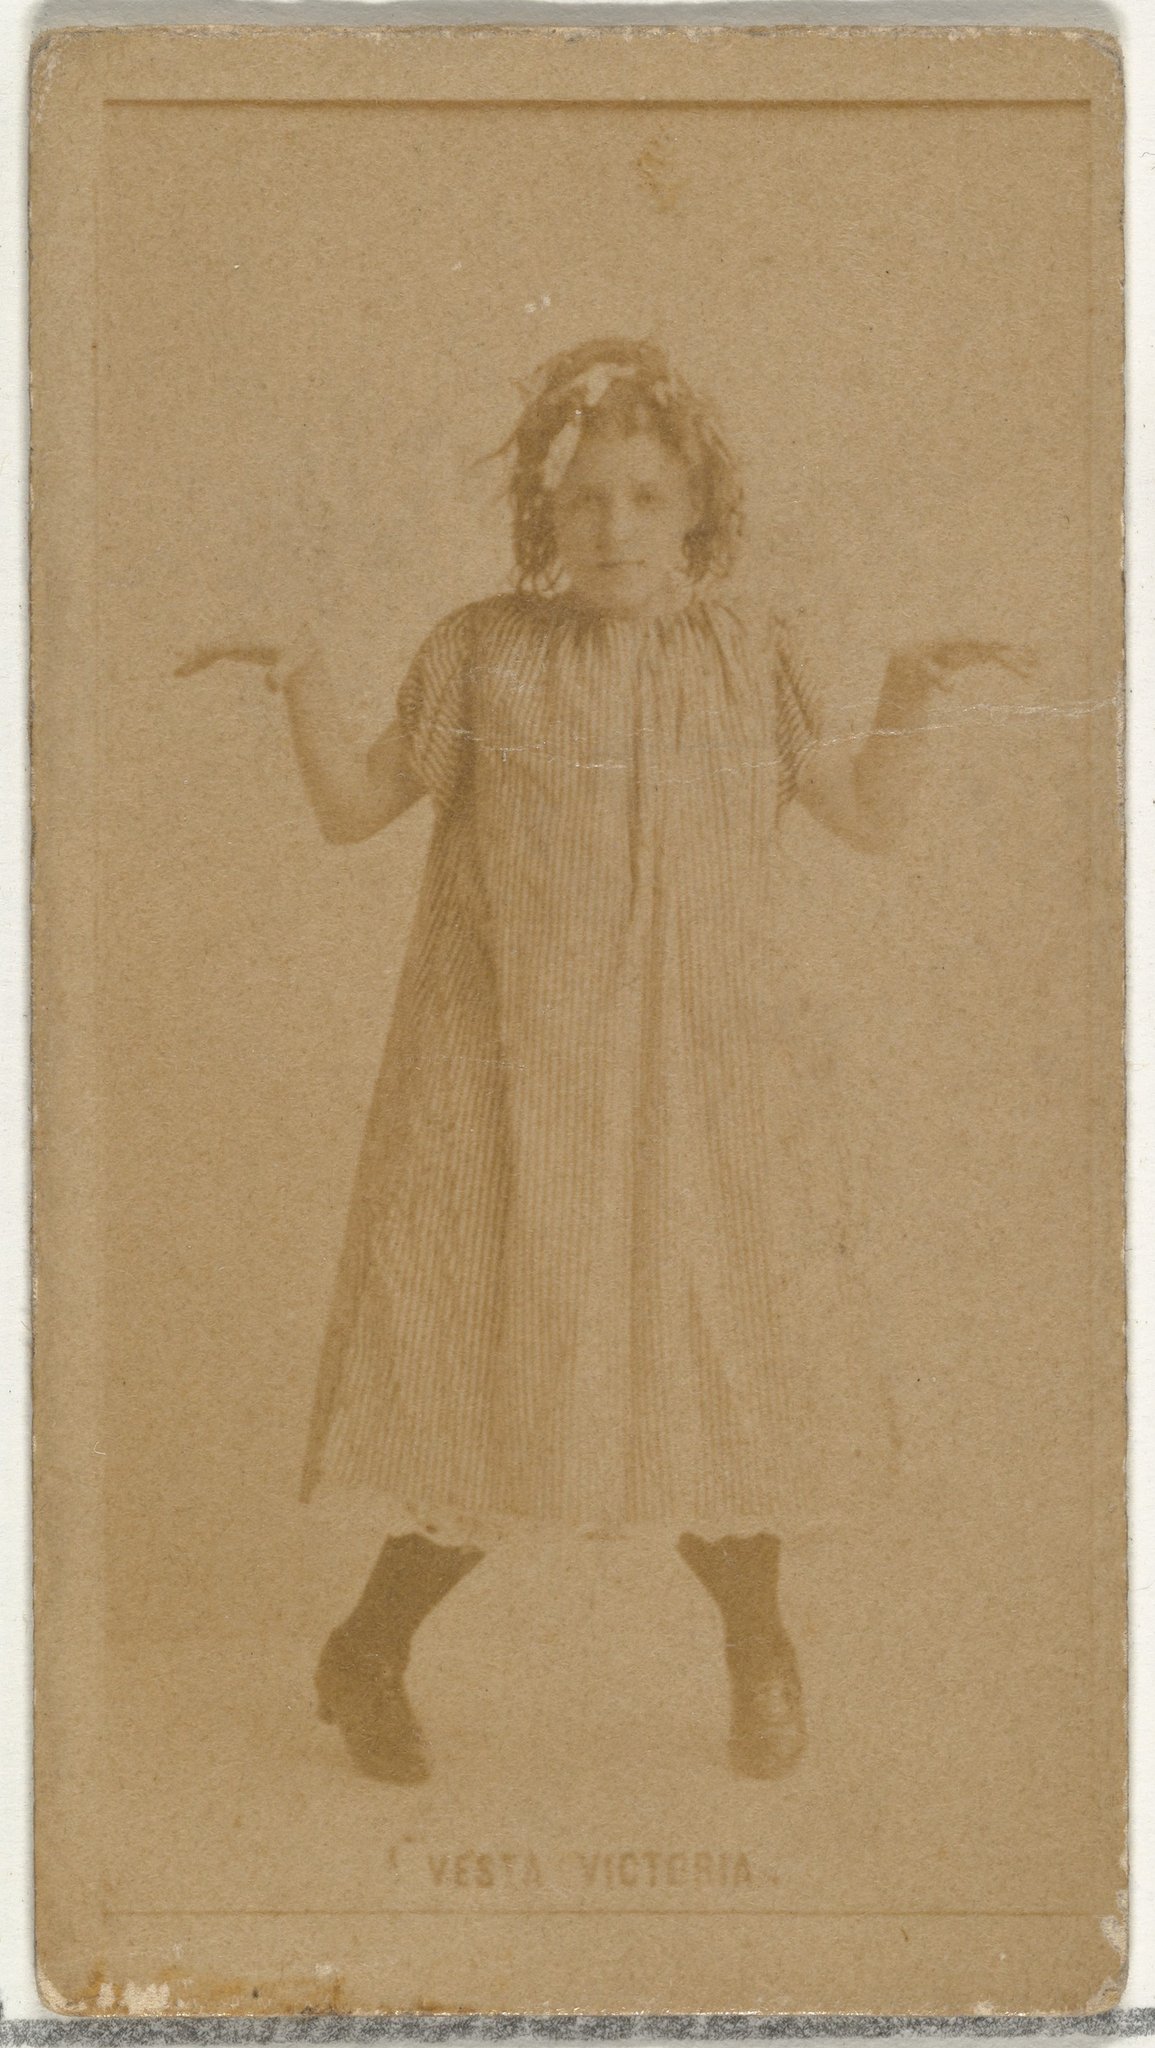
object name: photograph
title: Vesta Victoria, from the Actors and Actresses series (N145-8) issued by Duke Sons & Co. to promote Duke Cigarettes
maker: w. duke, sons & co.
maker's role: publisher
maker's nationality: american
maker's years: 1870-1920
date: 1891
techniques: albumen silver print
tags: portraits,women,actresses